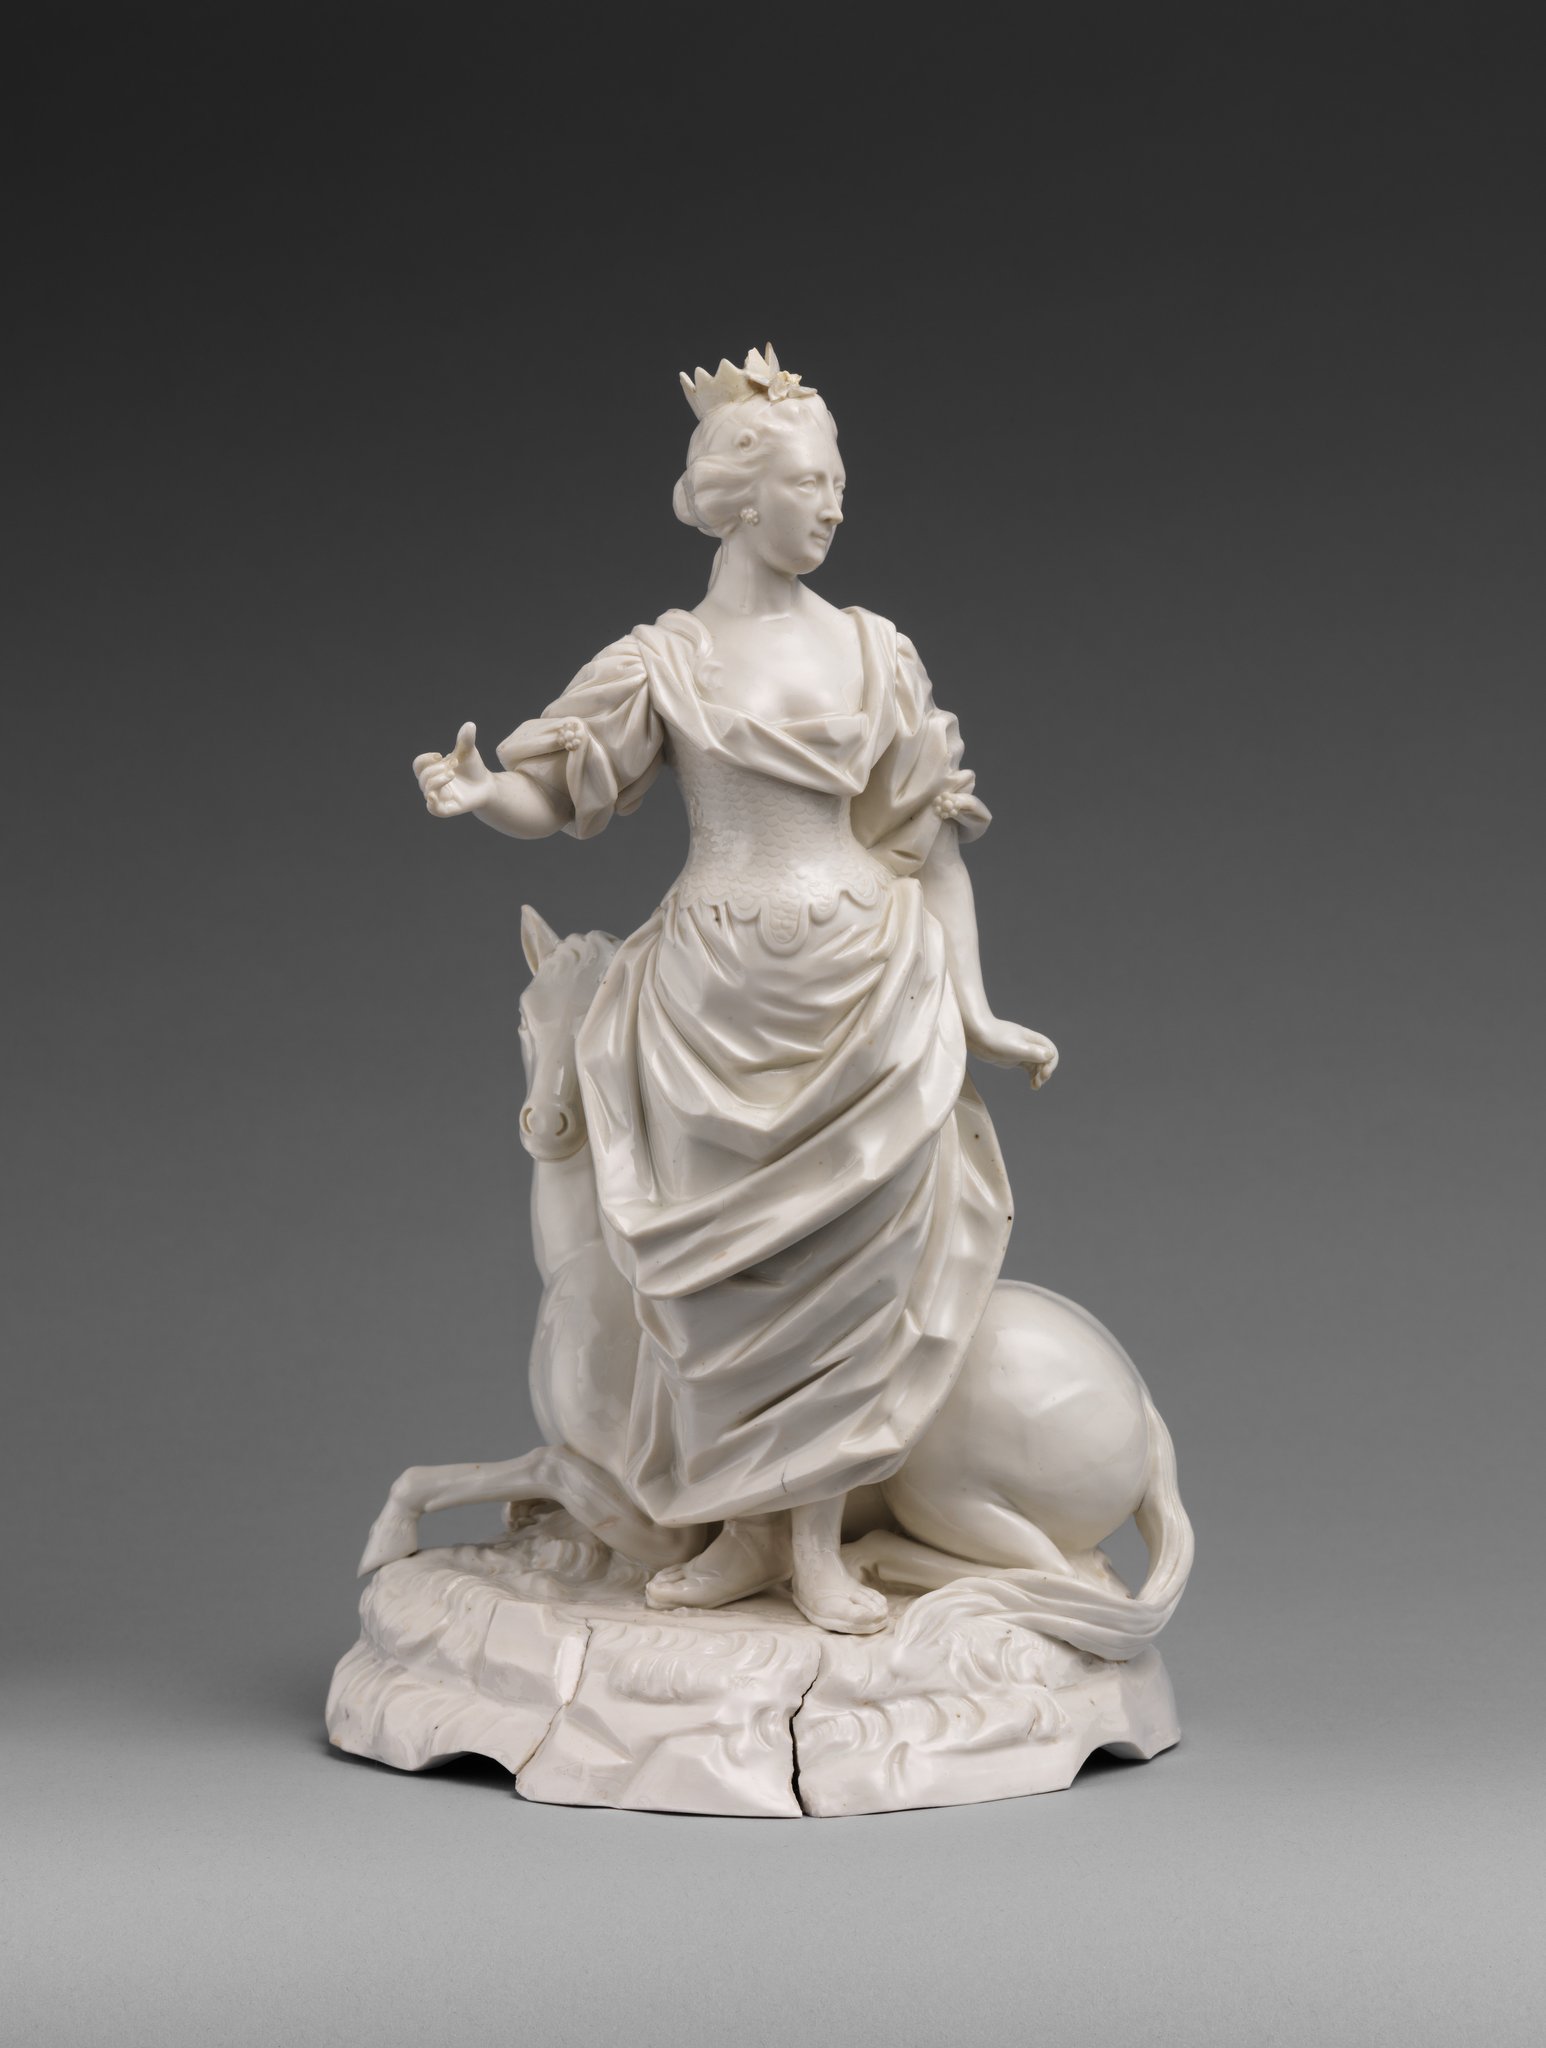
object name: figure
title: Europe, from Allegories of the Four Continents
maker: fulda pottery and porcelain manufactory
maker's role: manufactory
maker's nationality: german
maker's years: 1764-1789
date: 1781-1788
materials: hard paste porcelain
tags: europa